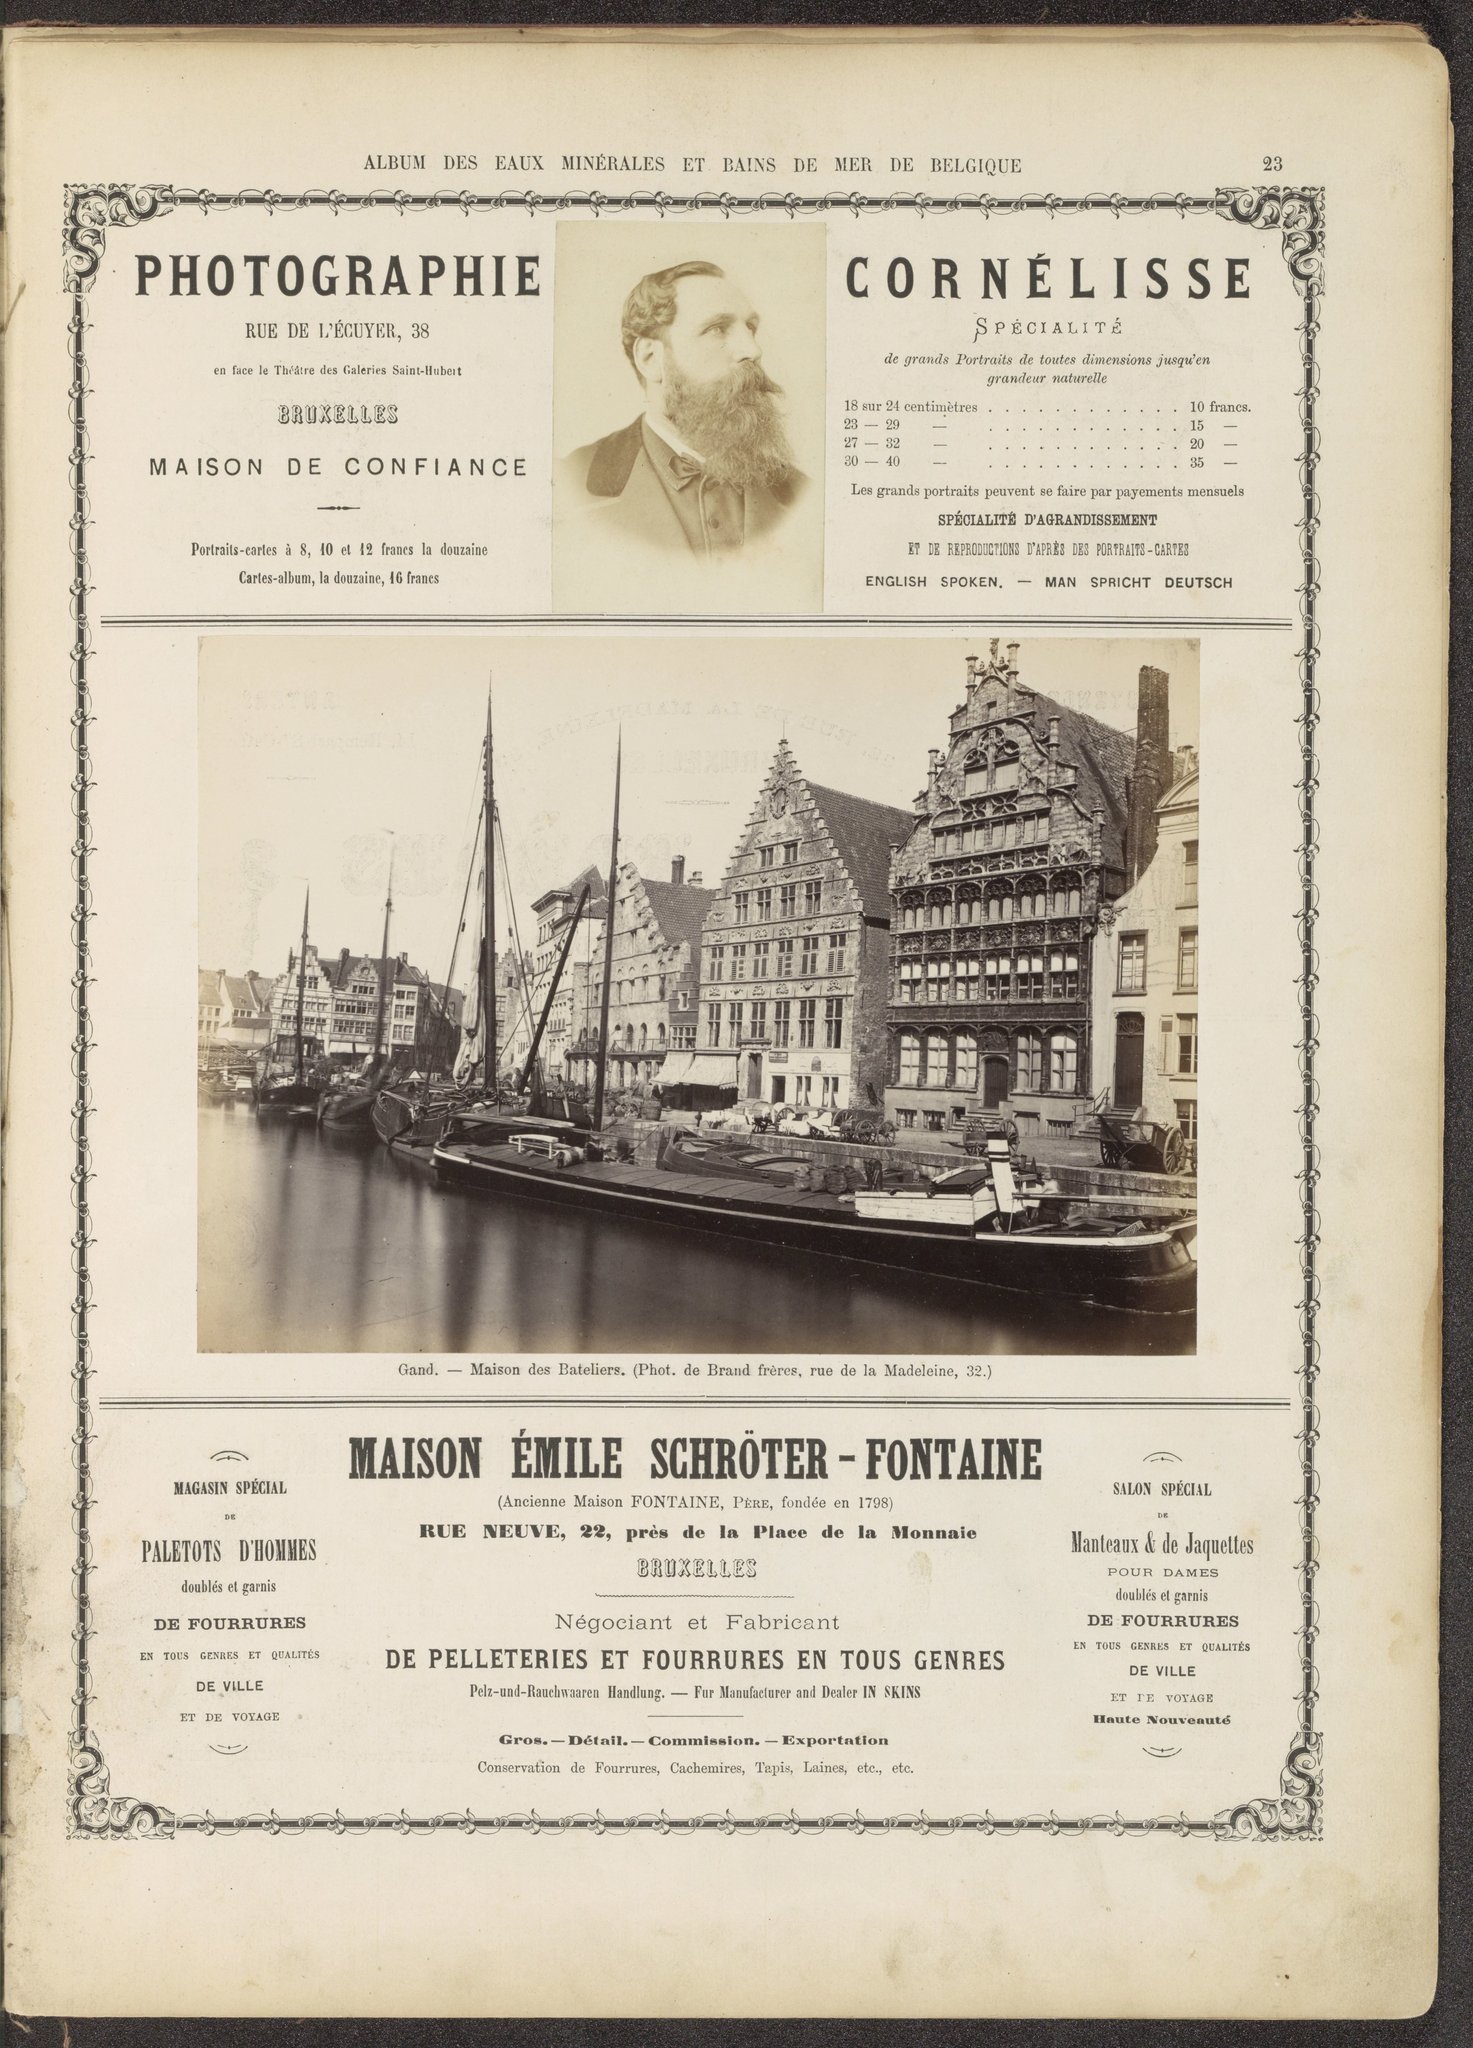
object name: photograph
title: Gand - Maison des Bateliers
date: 1862-1872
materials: photographic support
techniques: albumen print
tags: anonymous historical person portrayed, façade (of house or building), quay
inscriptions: name: ‘(Phot. de Brand frères, rue de la Madeleine, 32.)’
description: Boven een portret van een man met een baard, onder een gezicht op de Graslei te Gent.